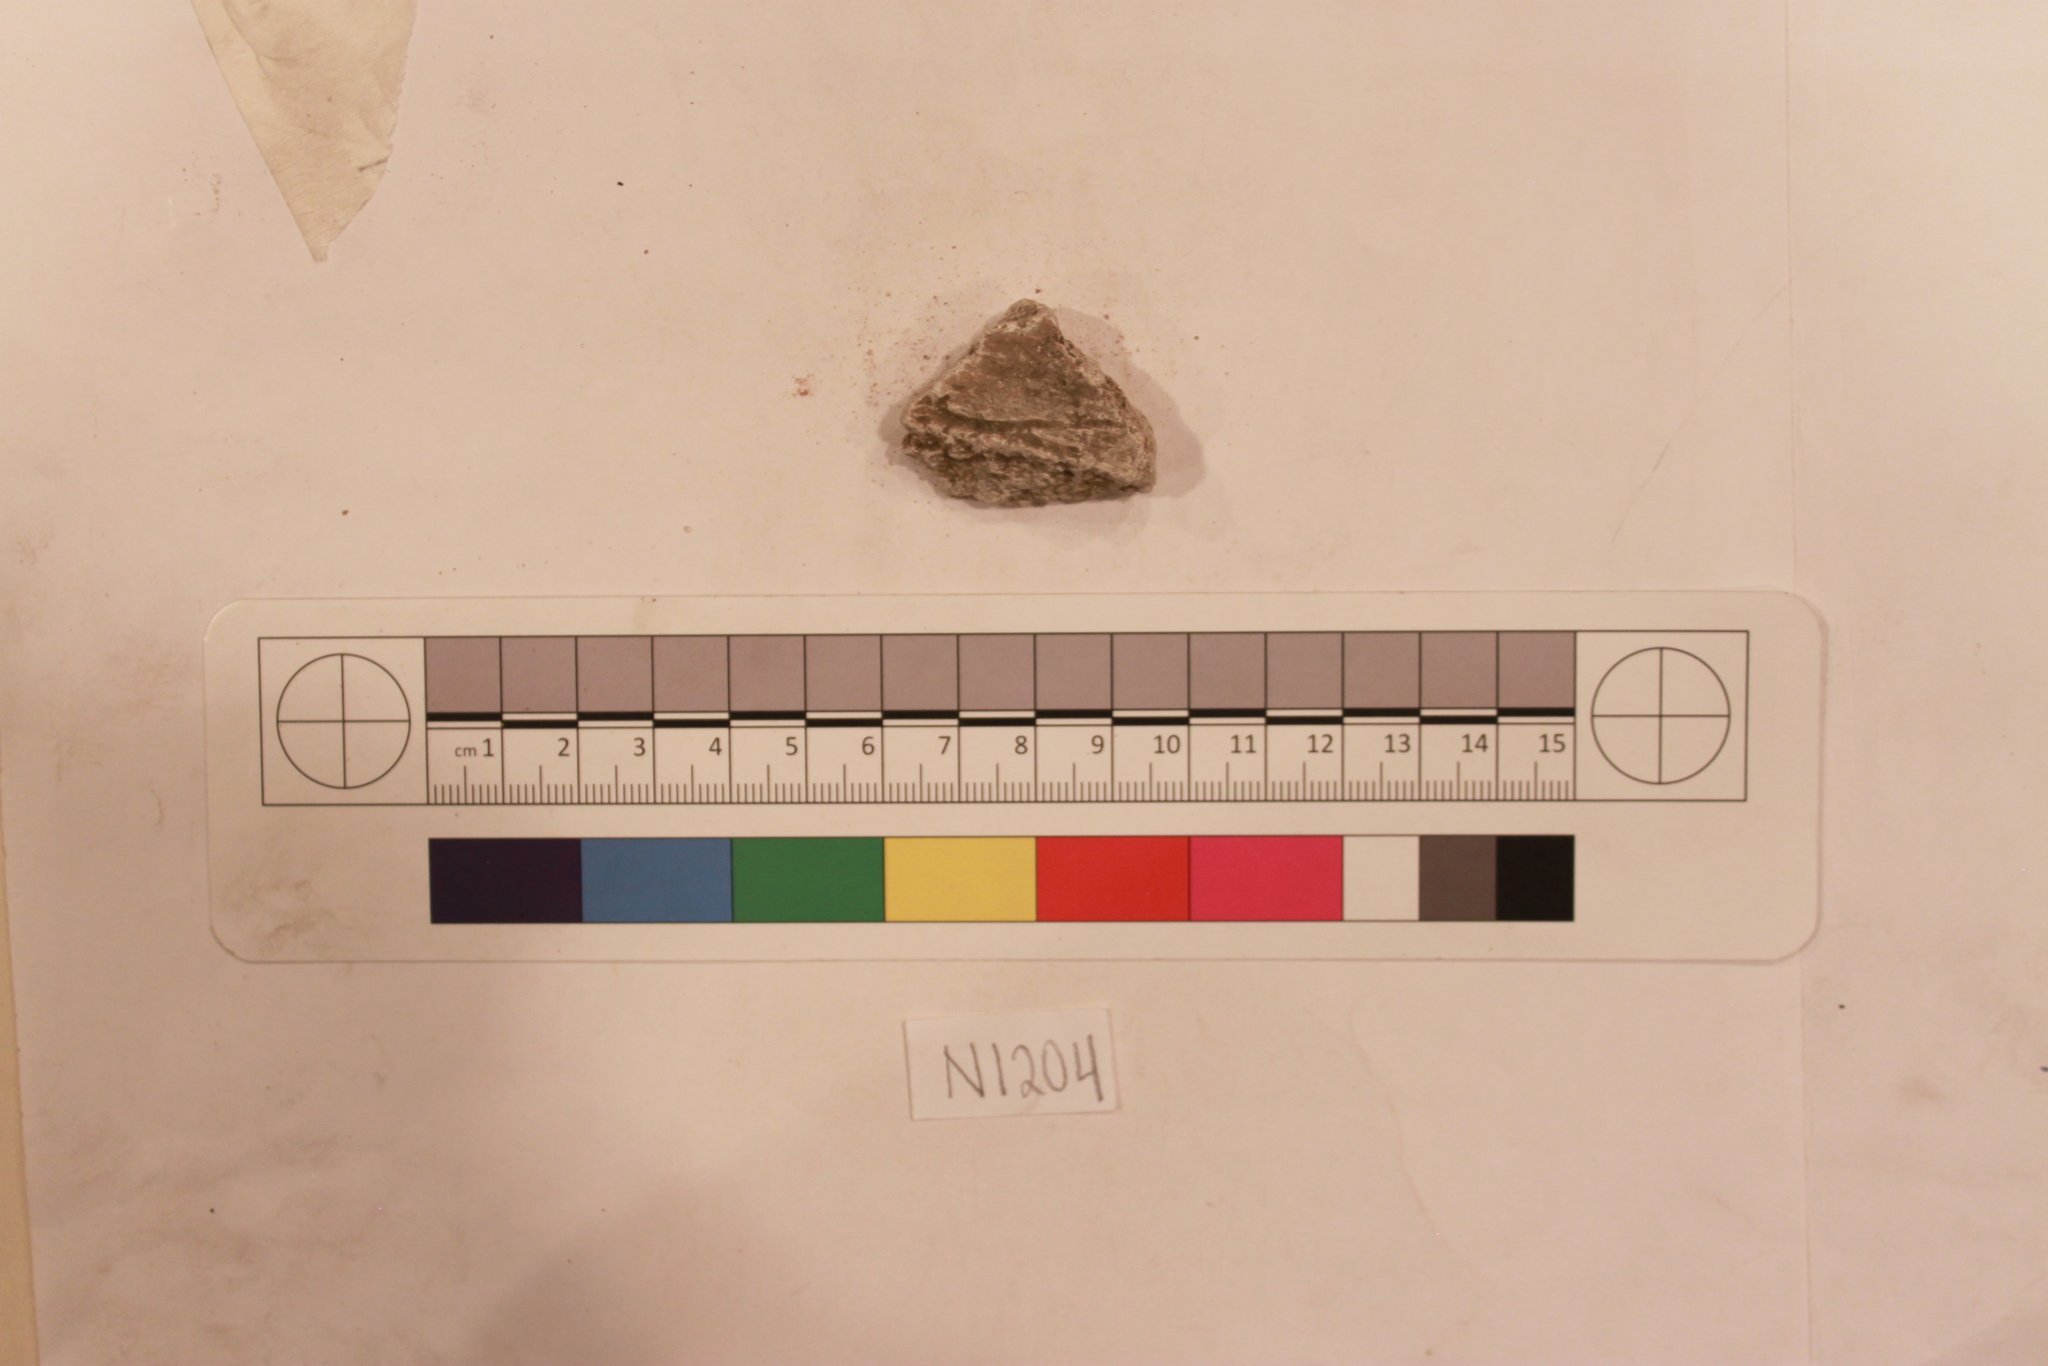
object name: fragment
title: Stucco Fragment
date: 701-1200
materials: plaster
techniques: carving, painting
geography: iran